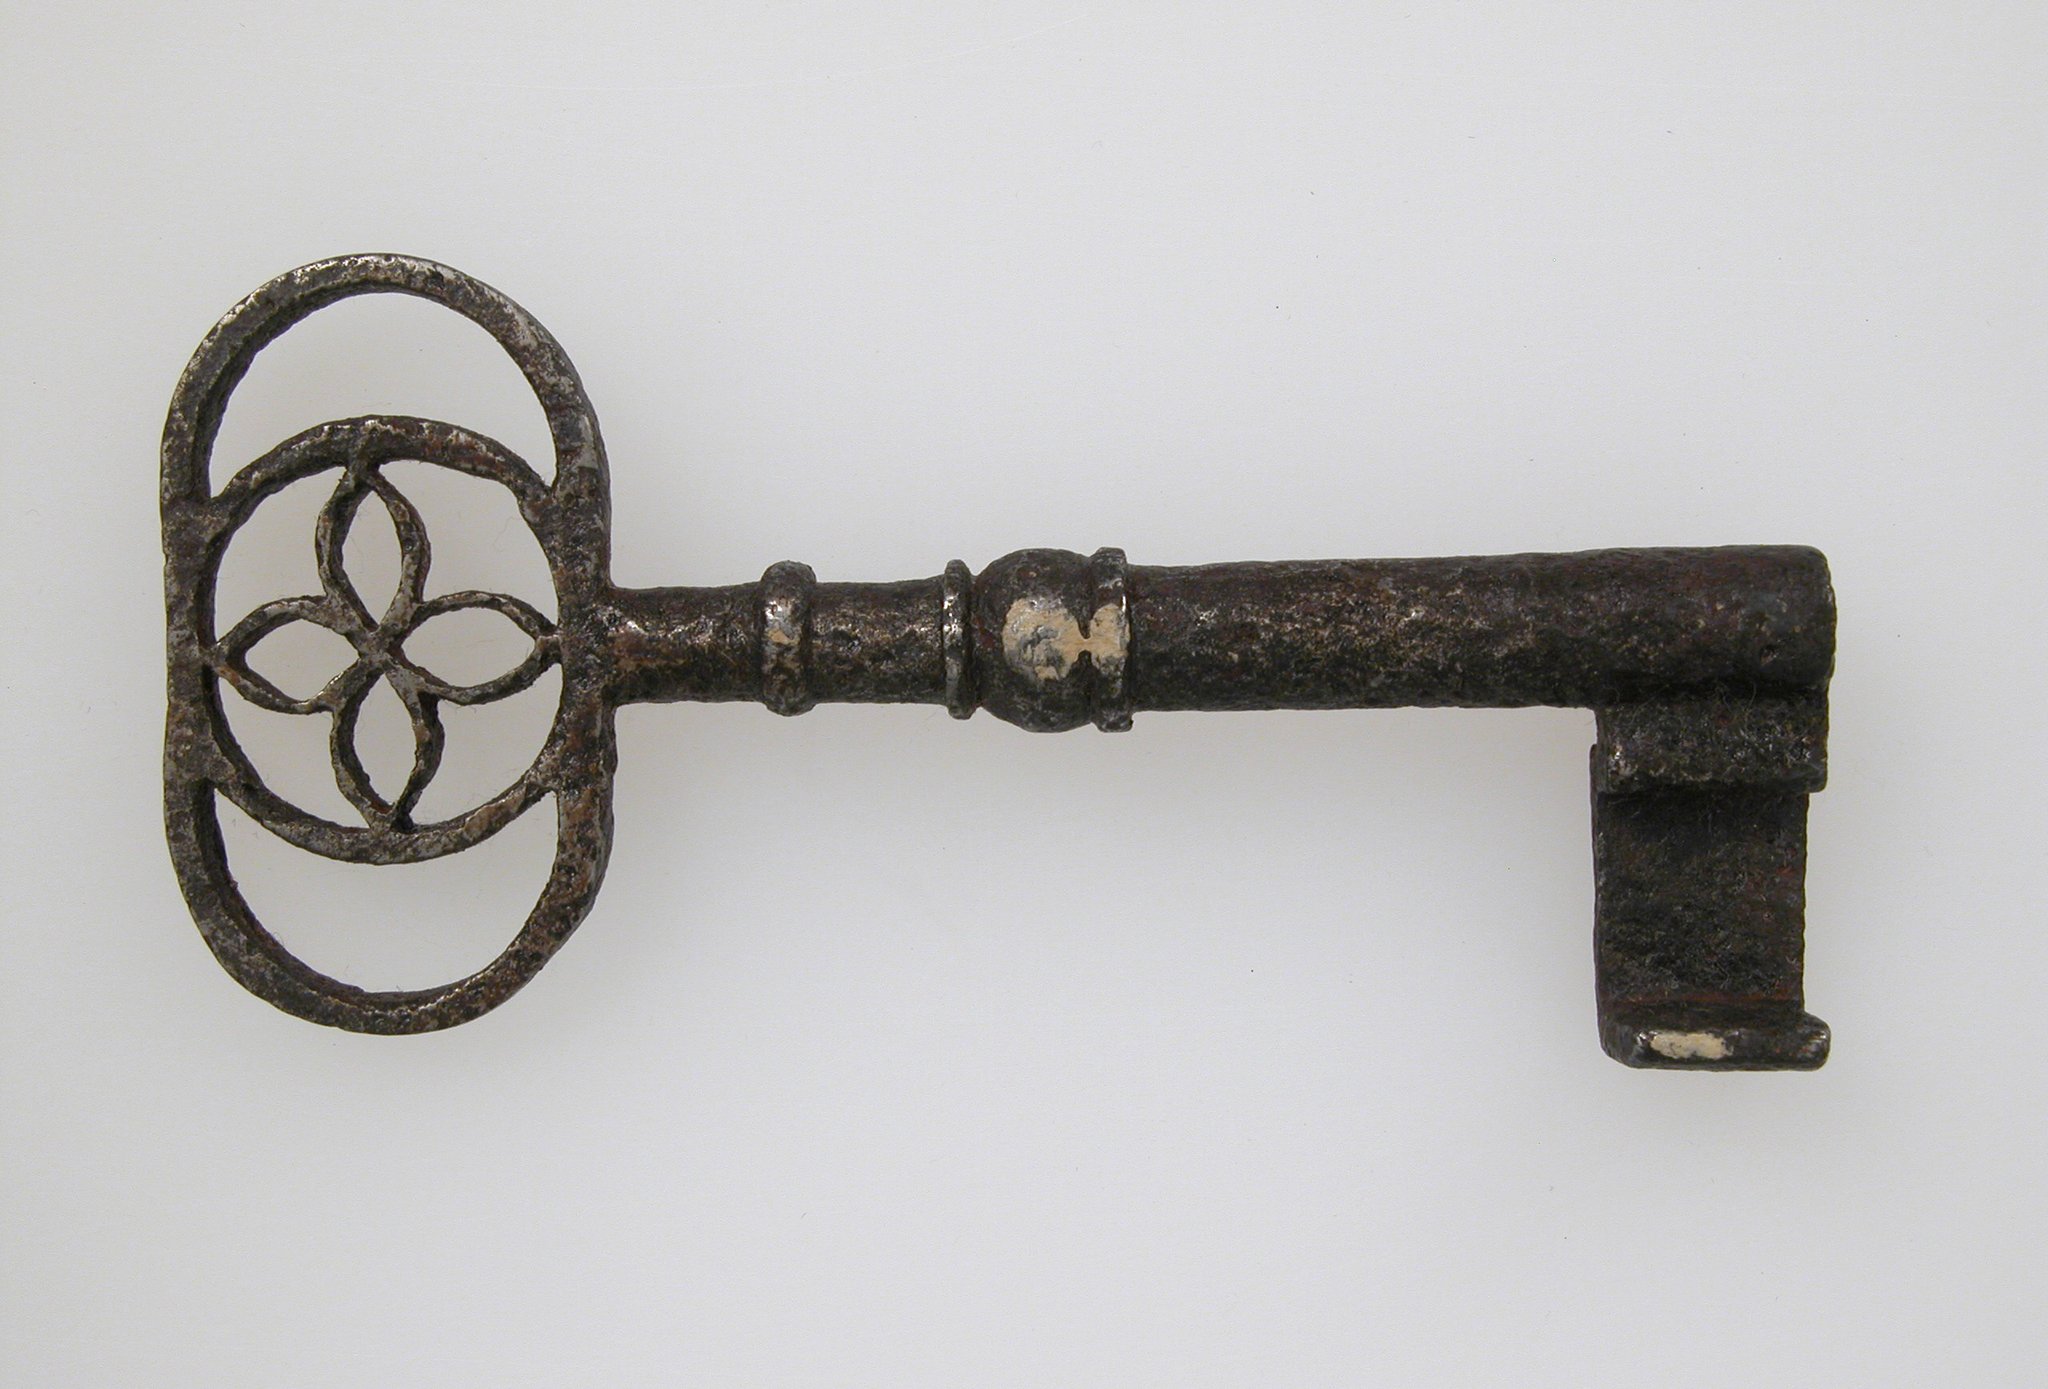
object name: key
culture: german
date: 1401-1500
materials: iron